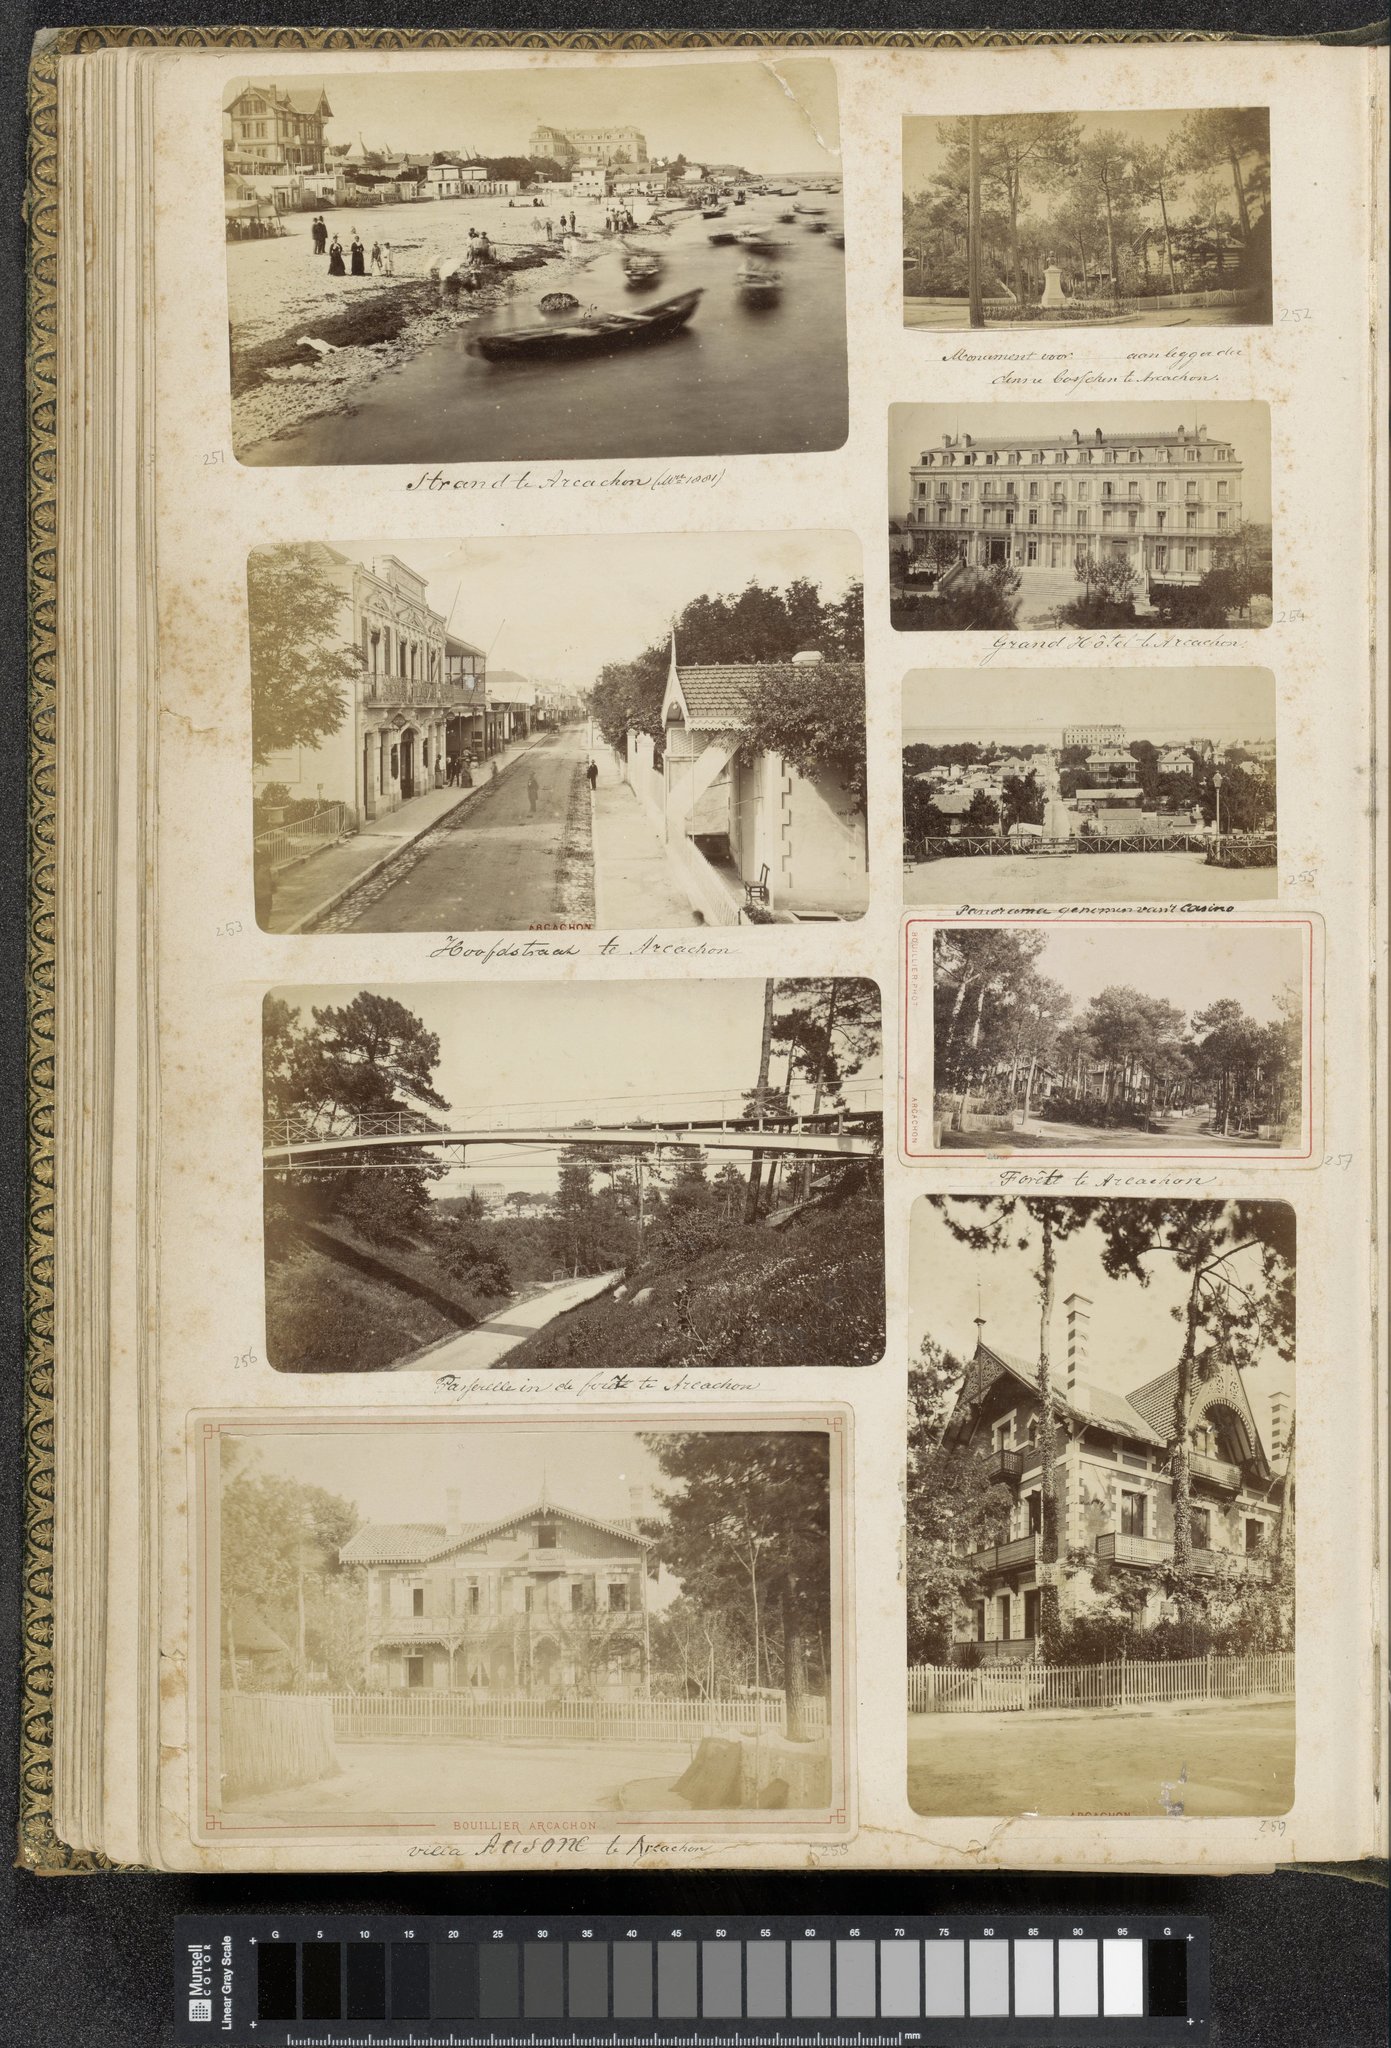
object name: photograph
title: Gezicht op de hoofdstraat van Arcachon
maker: Anonymous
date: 1870-1880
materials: paper, photographic support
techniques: albumen print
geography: arcachon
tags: street (+ city(-scape) with figures, staffage)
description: Onderdeel van Fotoalbum van Robert Daniel Crommelin (1841-1907).